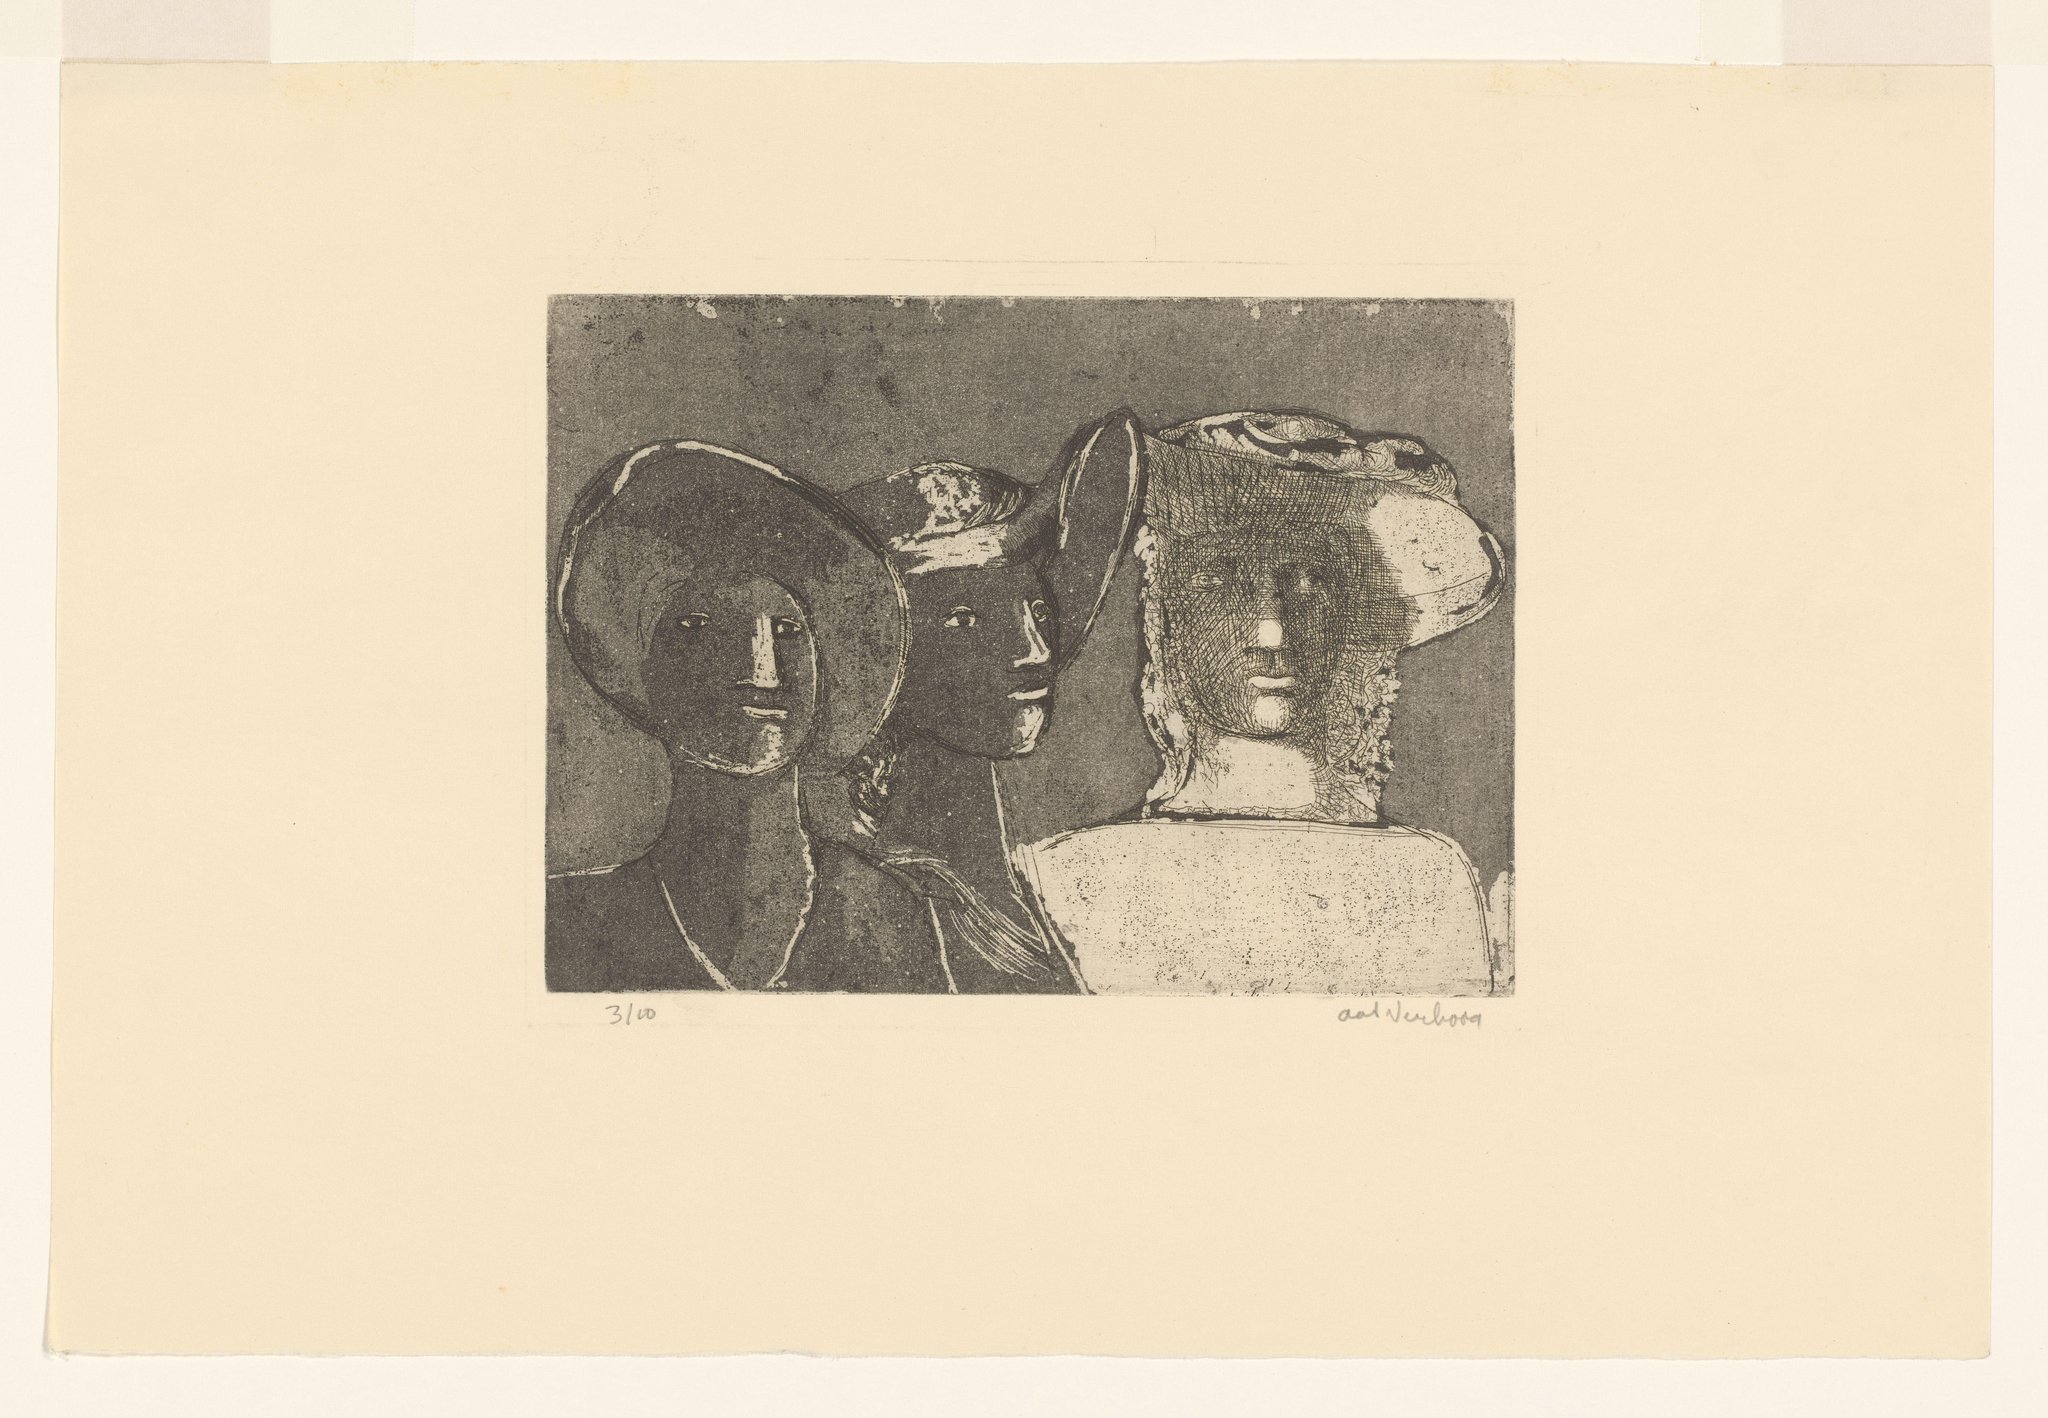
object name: print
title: Faire le grand tour du monde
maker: aat verhoog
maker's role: print maker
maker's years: 1933-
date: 1943-1958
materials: paper, ink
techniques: aquatint, etching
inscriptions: edition: ‘3/10’, signature: ‘Aat Verhoog’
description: De huidige titel is door het Rijksmuseum overgenomen van het Instituut Collectie Nederland.